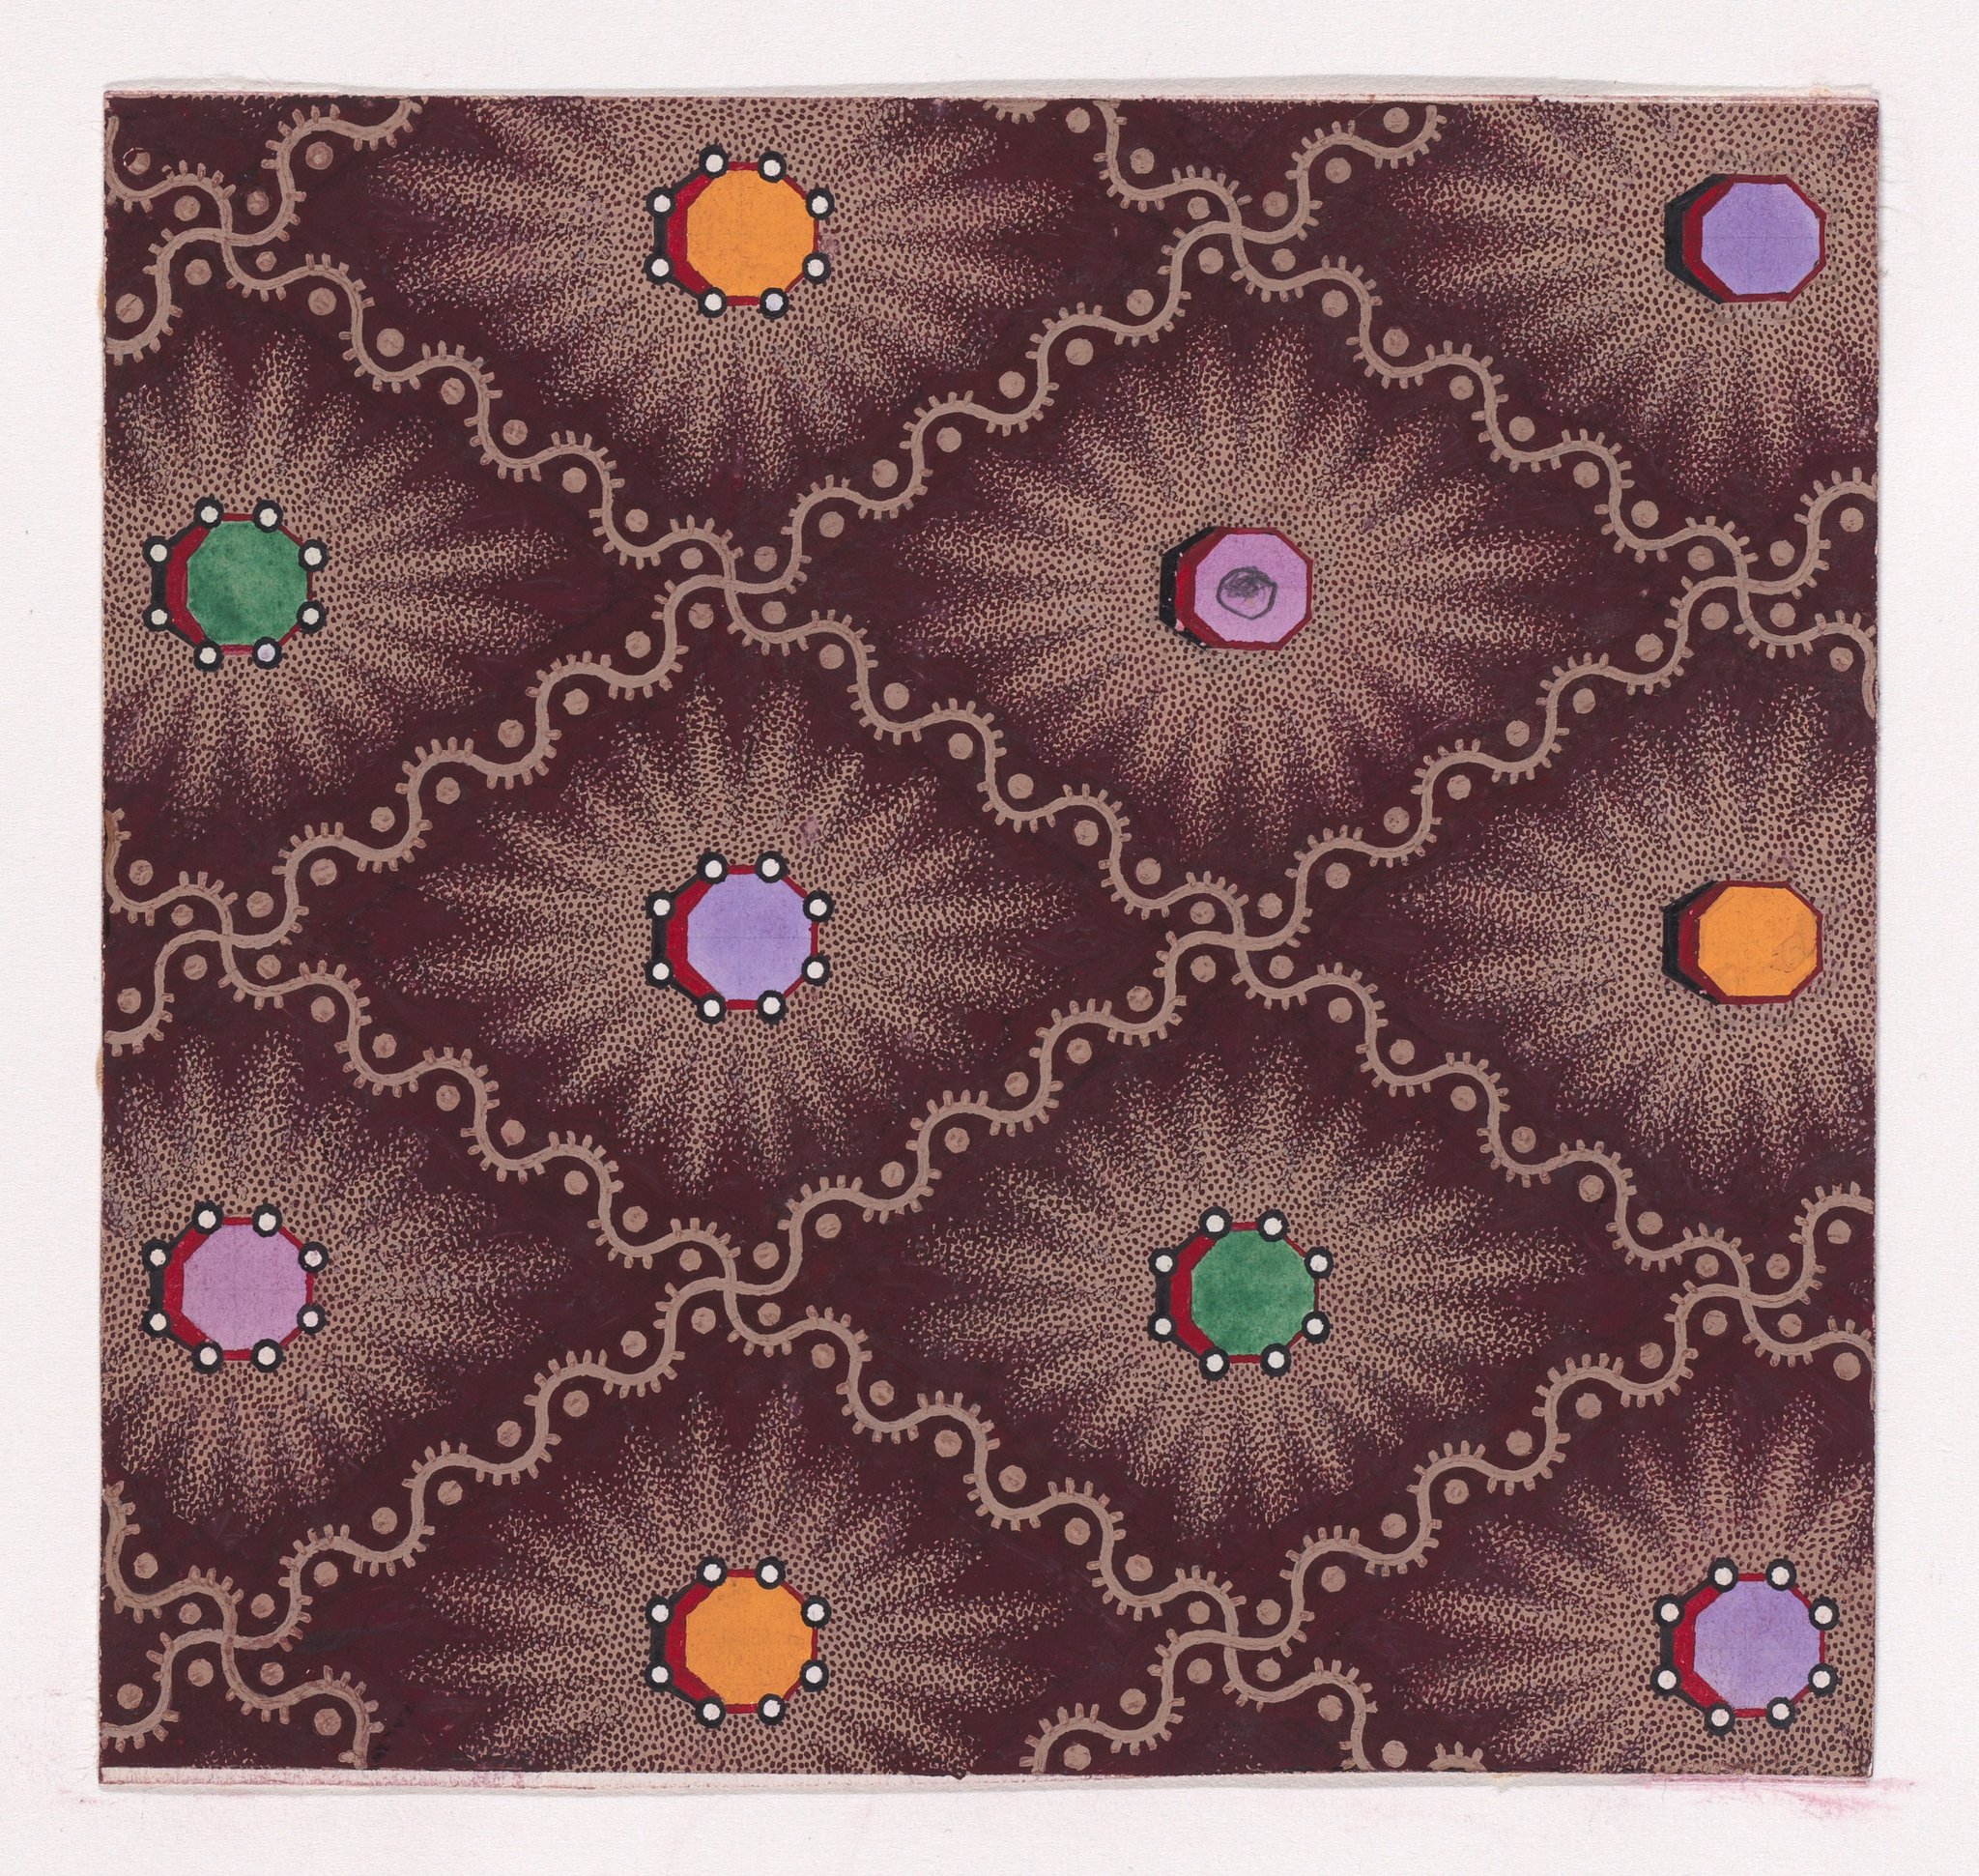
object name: drawing ornament architecture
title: Textile Design with a Pattern of Seamless Lozenges Formed by a Undulating Ribbons with Dots, Decorated with Octagons with Pearls on the Vertices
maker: anonymous, alsatian, 19th century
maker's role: artist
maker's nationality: alsatian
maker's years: 1800-1900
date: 1840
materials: gouache